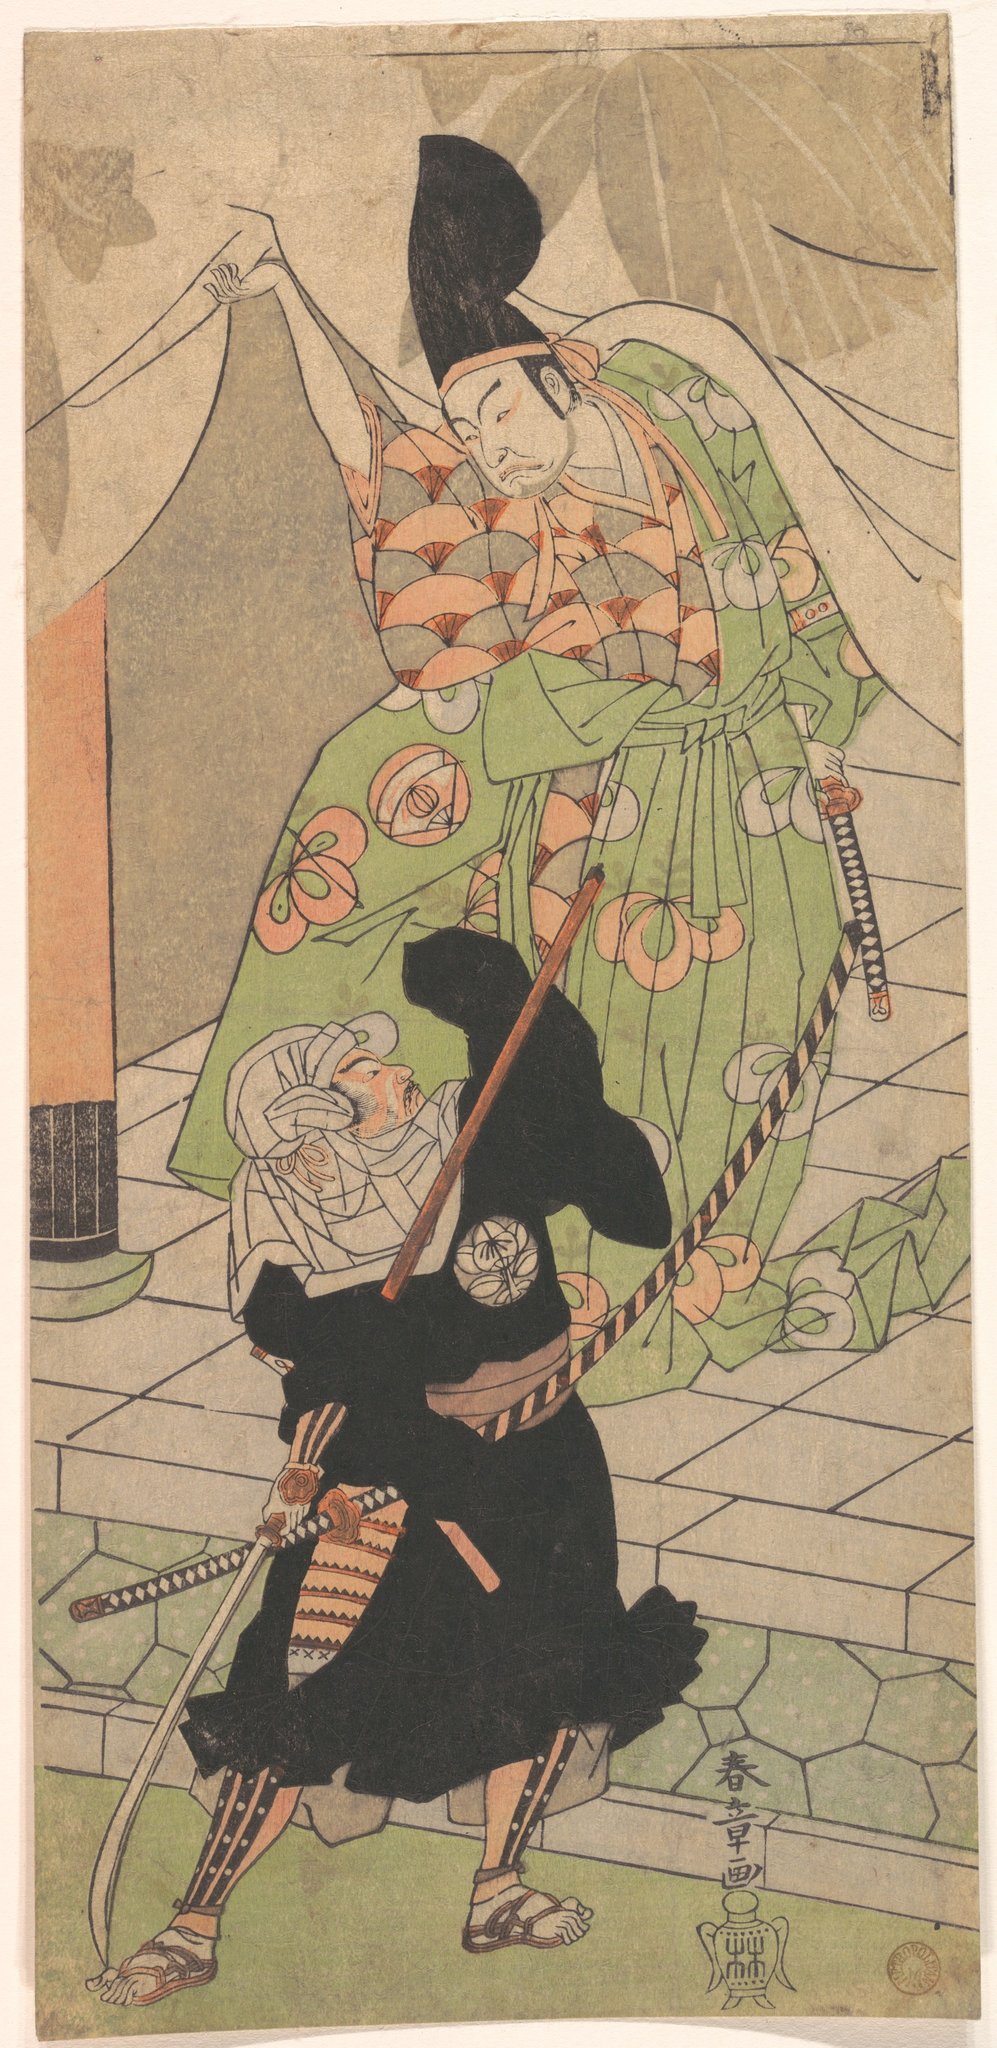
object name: woodblock print nishiki e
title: The Messenger in Black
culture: japanese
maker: katsukawa shunshō 勝川春章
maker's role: artist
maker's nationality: japanese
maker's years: 1726-1792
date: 1726-1792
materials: ink, paper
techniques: nishiki e, woodblock print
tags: swords,men